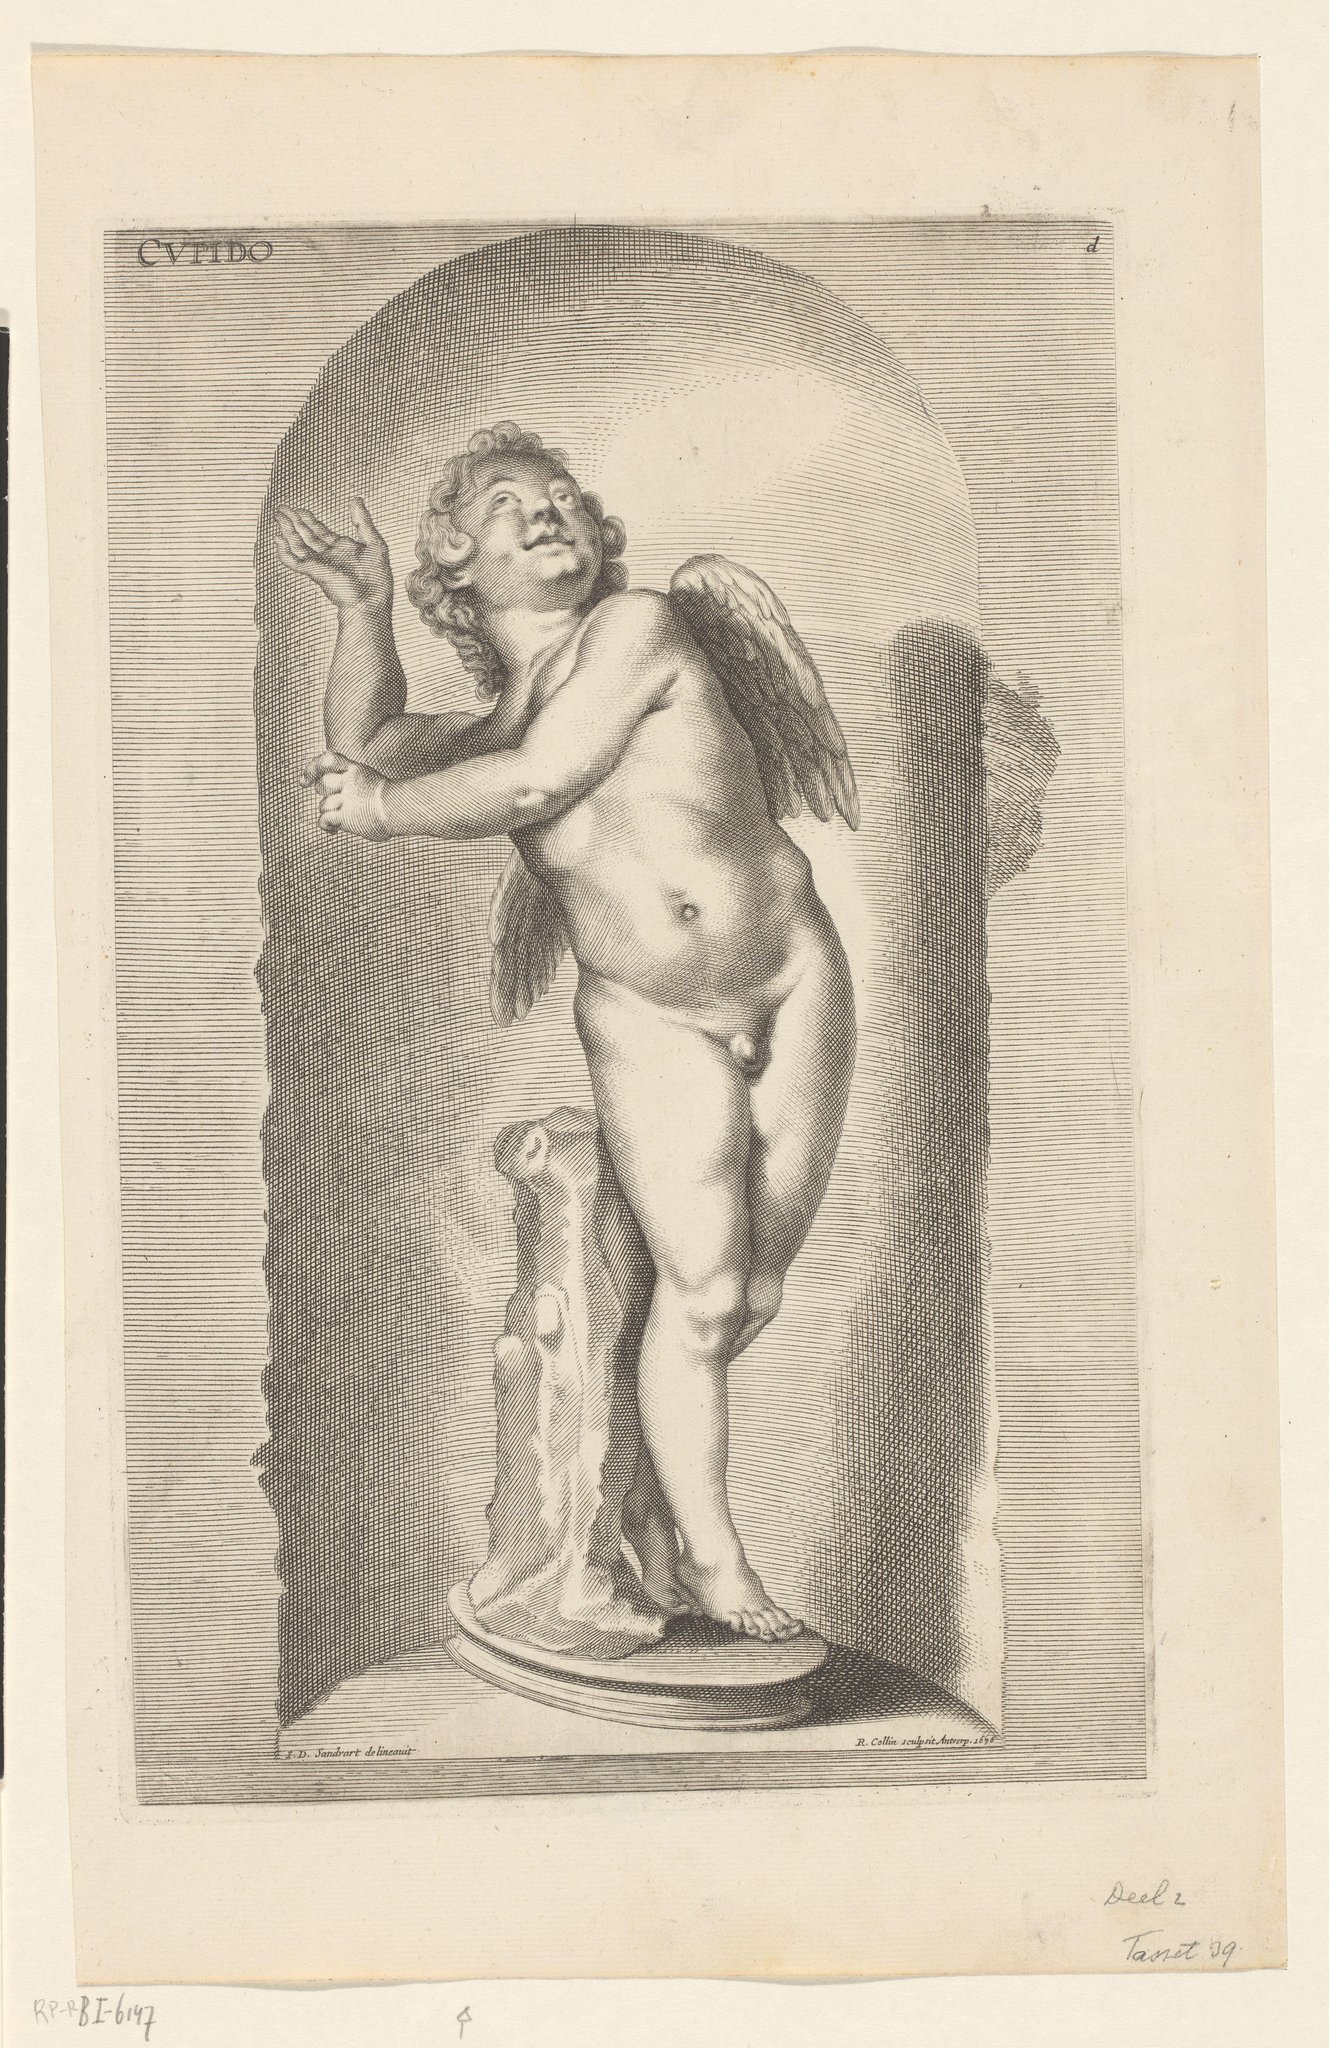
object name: print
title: Cupido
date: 1676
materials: paper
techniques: engraving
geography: antwerp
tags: piece of sculpture, reproduction of a piece of sculpture, (story of) cupid, amor (eros)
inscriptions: collector's mark: Lugt 2228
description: Illustratie voor: Joachim von Sandrart, L'Academia Todesca della Architectura Scultura e Pittura oder Teutsche Academie der Edlen Bau-, Bild- und Mahlerey-Künste. Nürnberg: 1675-1680. Deel 2.